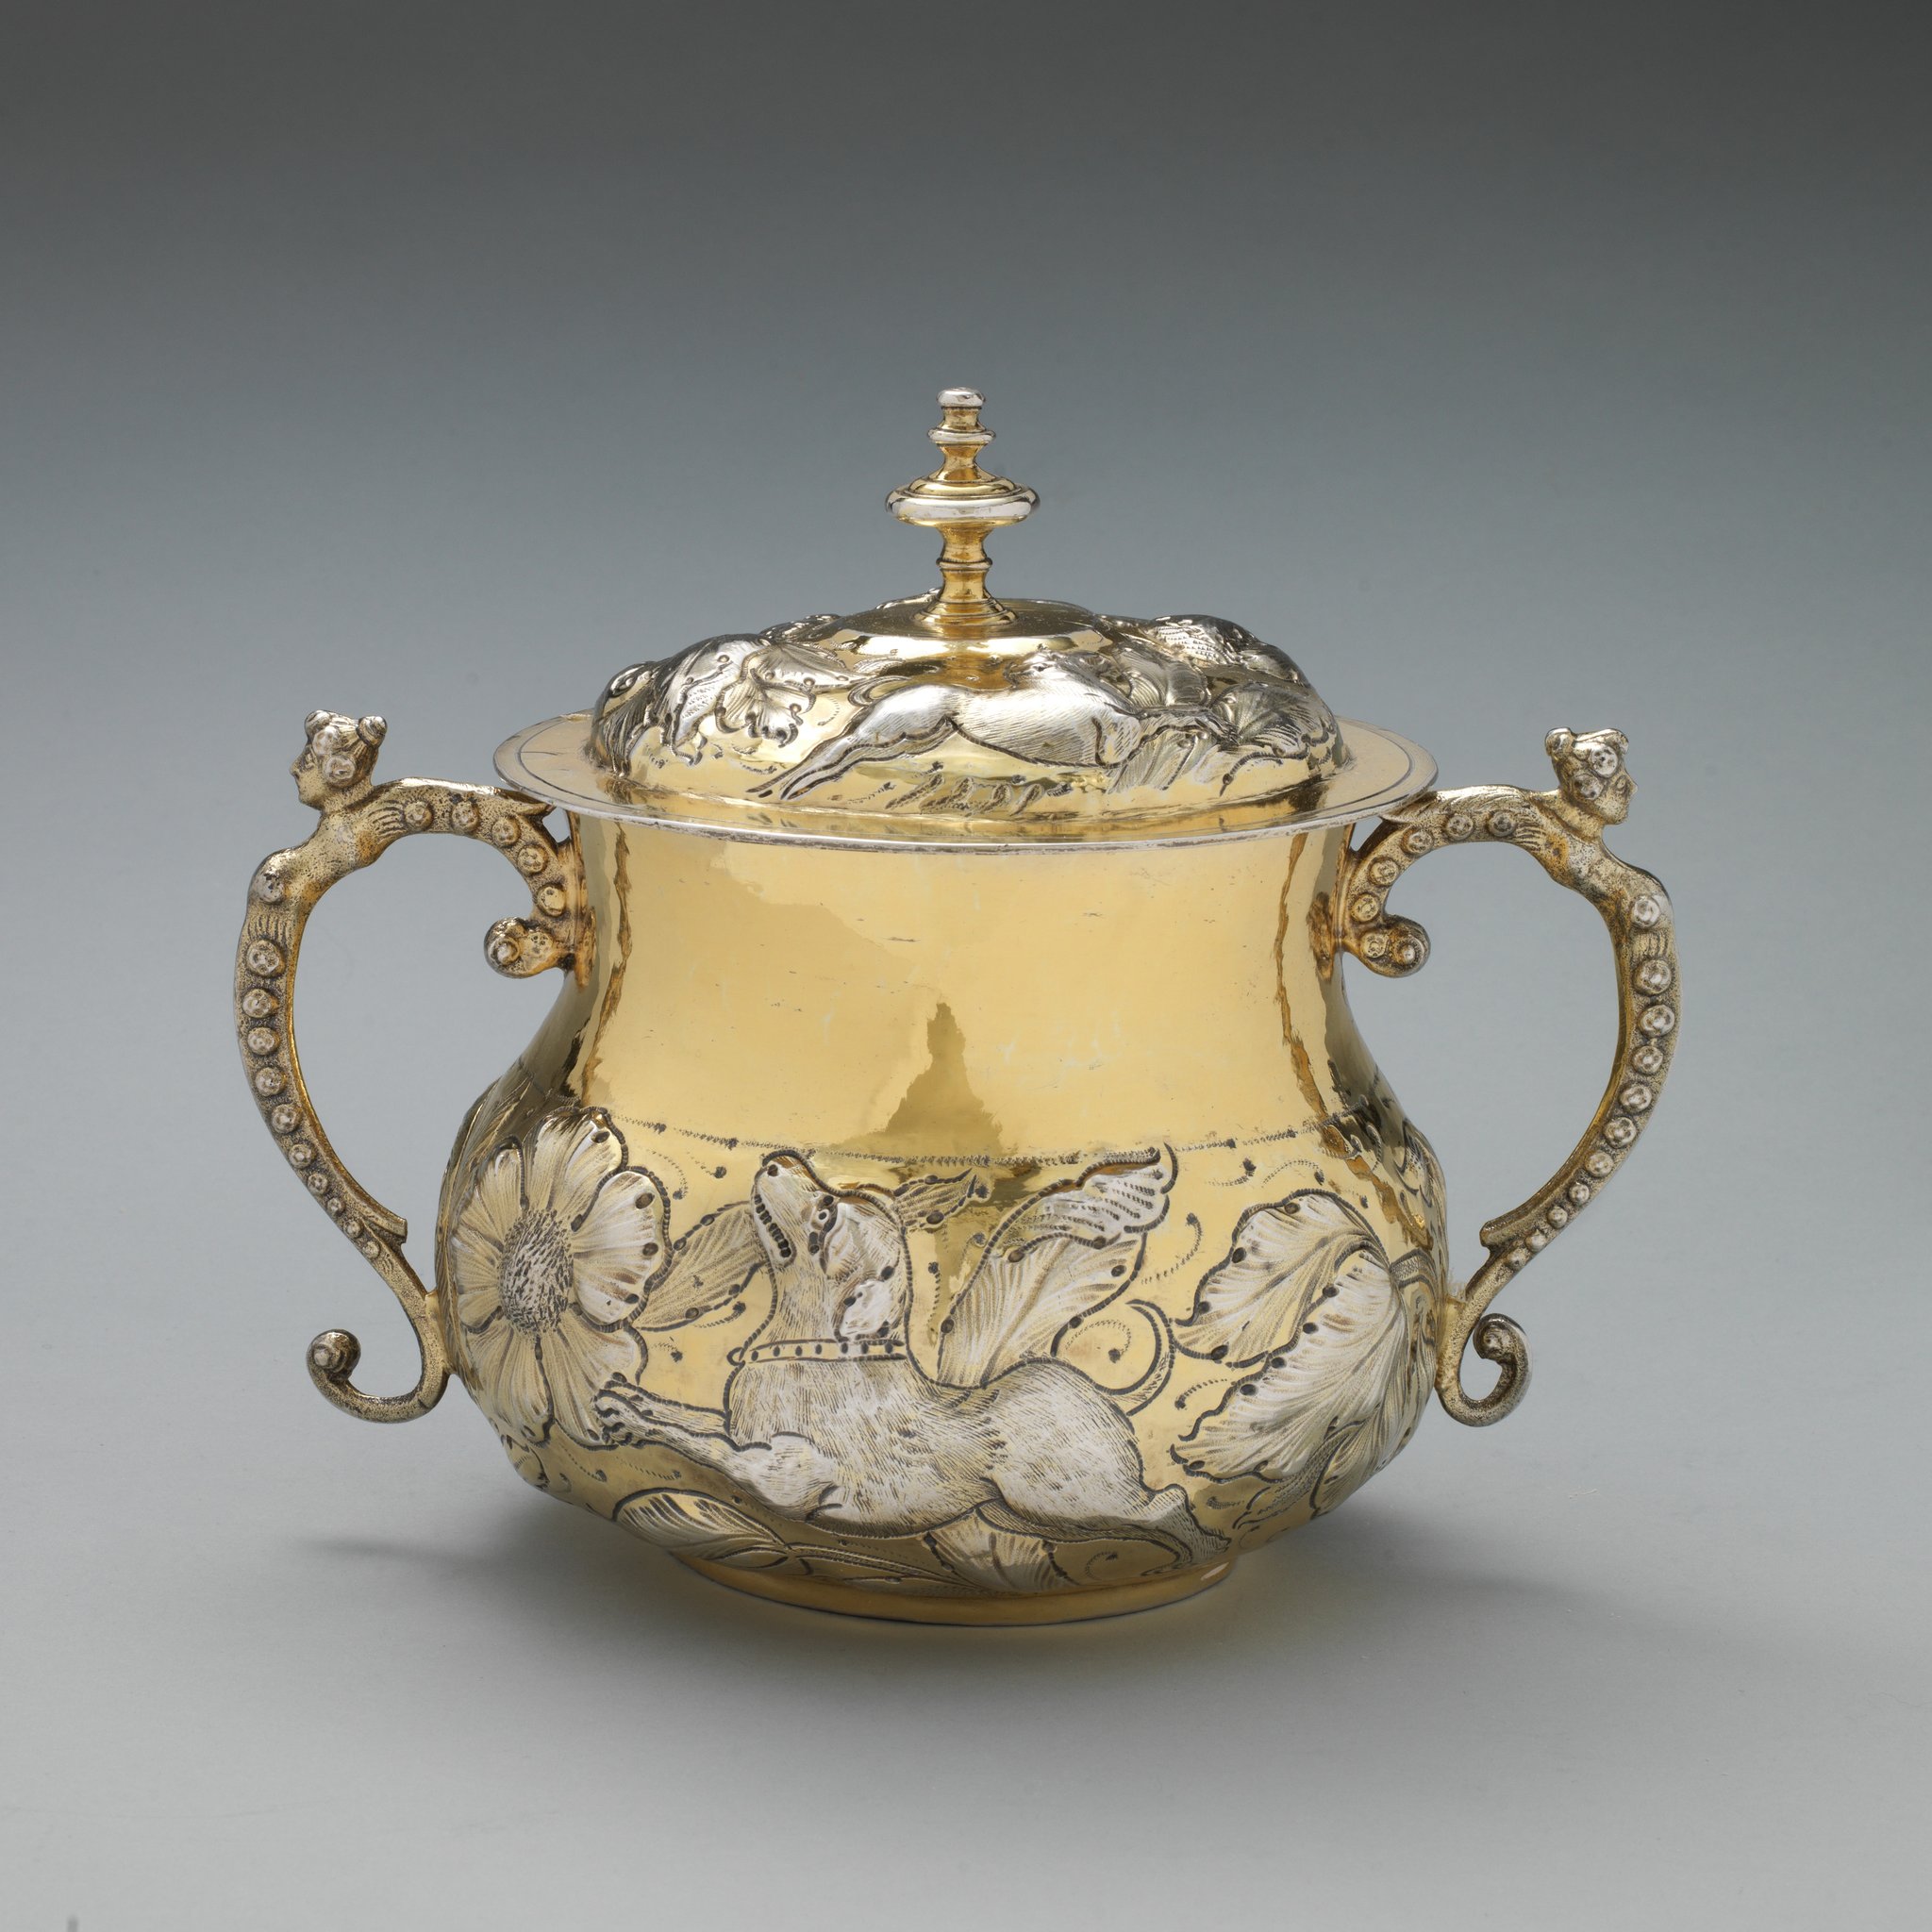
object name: cup with cover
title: Two-handled cup with cover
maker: francis leake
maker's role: maker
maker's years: 1655-1683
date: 1669-1670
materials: silver gilt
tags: dogs,flowers